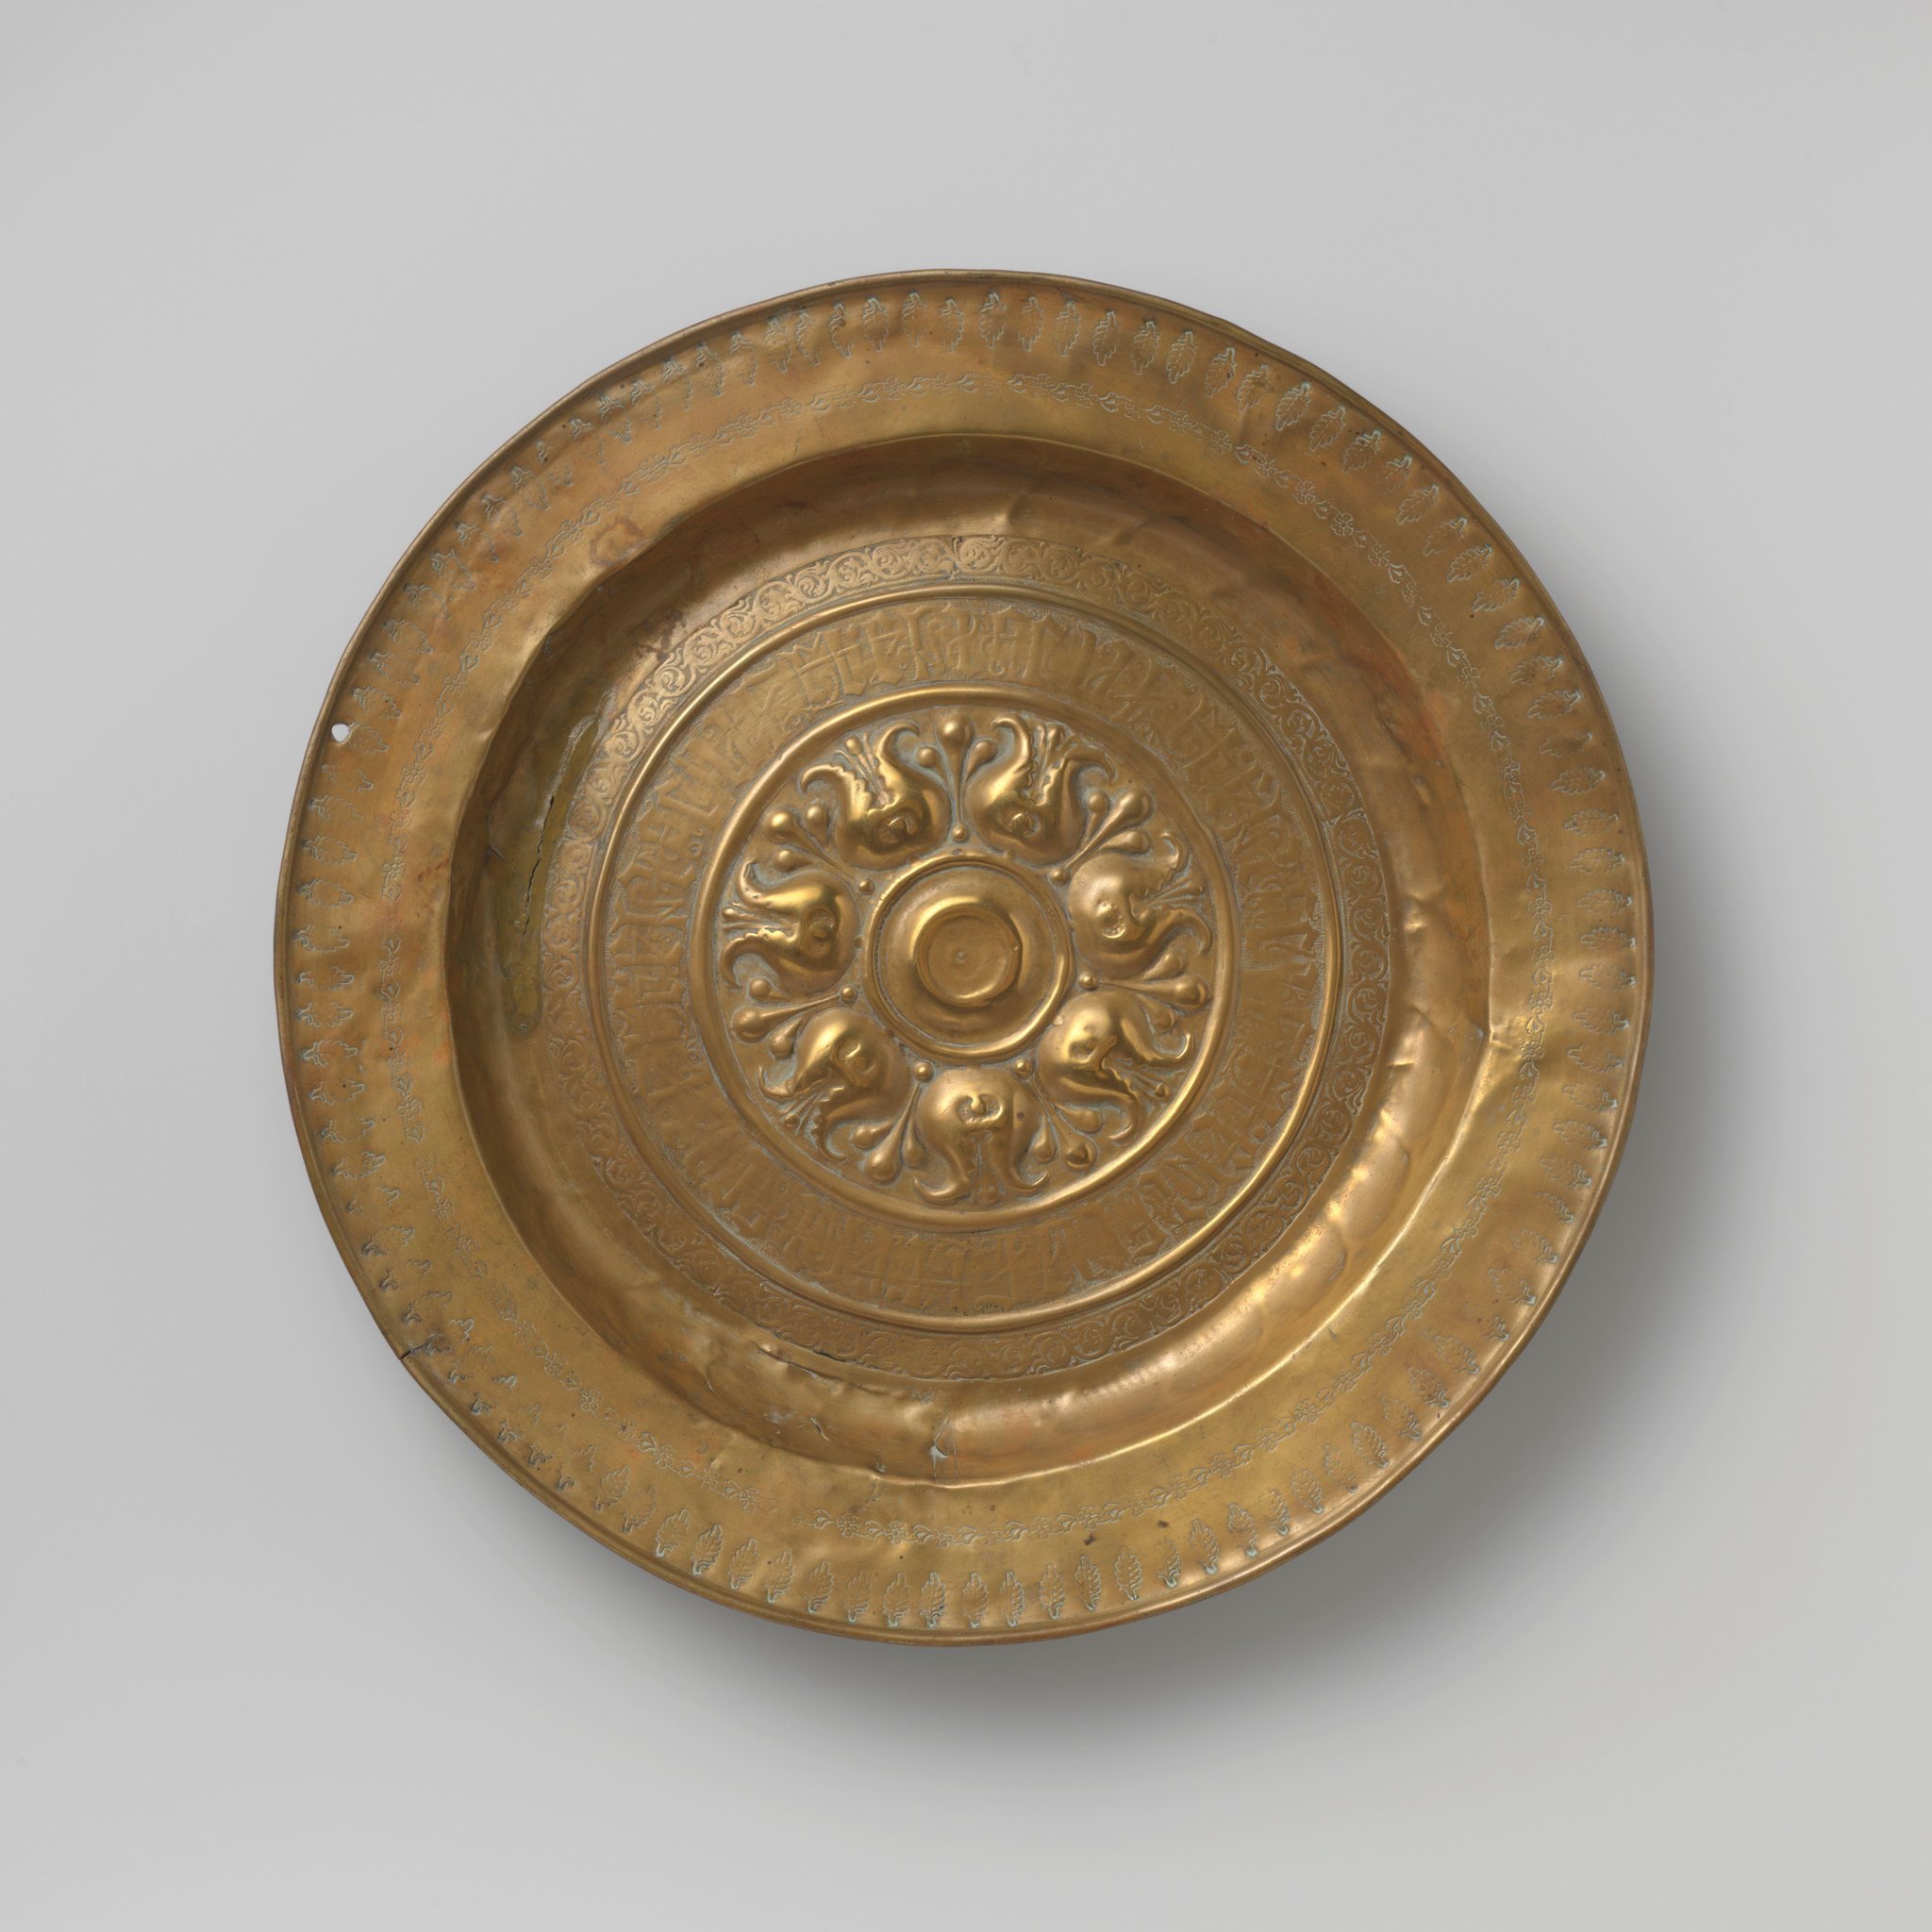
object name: platter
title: Schotel kelkvormige bloemen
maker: Anonymous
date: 1475-1525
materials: brass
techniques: casting, punching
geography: nuremberg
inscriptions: inscription: ‘GOTT SEI MIT UNS (?) (vier maal herhaald)’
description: In het plat de schotel, dat in het midden het centerpunt heeft, zijn met behulp van stempelvormen geponst: een umbo, welke is omgeven door een herhaling van zeven maal de motieven van een kelkvormige bloem en een gestileerde tros met drie vruchten of bladeren, voorst een rand met het GOTT SEI MIT UNS (?) (vier maal herhaald). In de wand van de schotel zijn 25 visblazen gedreven. Verder is de boord van de schotel versierd met een ring van geponst ornament bestaande uit rozetten en bladeren in het midden en uit bladeren tegen de rand. De rand van de schotel is om ijzerdraad geslagen. Het gat in de rand is later aangebracht. Het centerpunt is een kleine opening geworden.